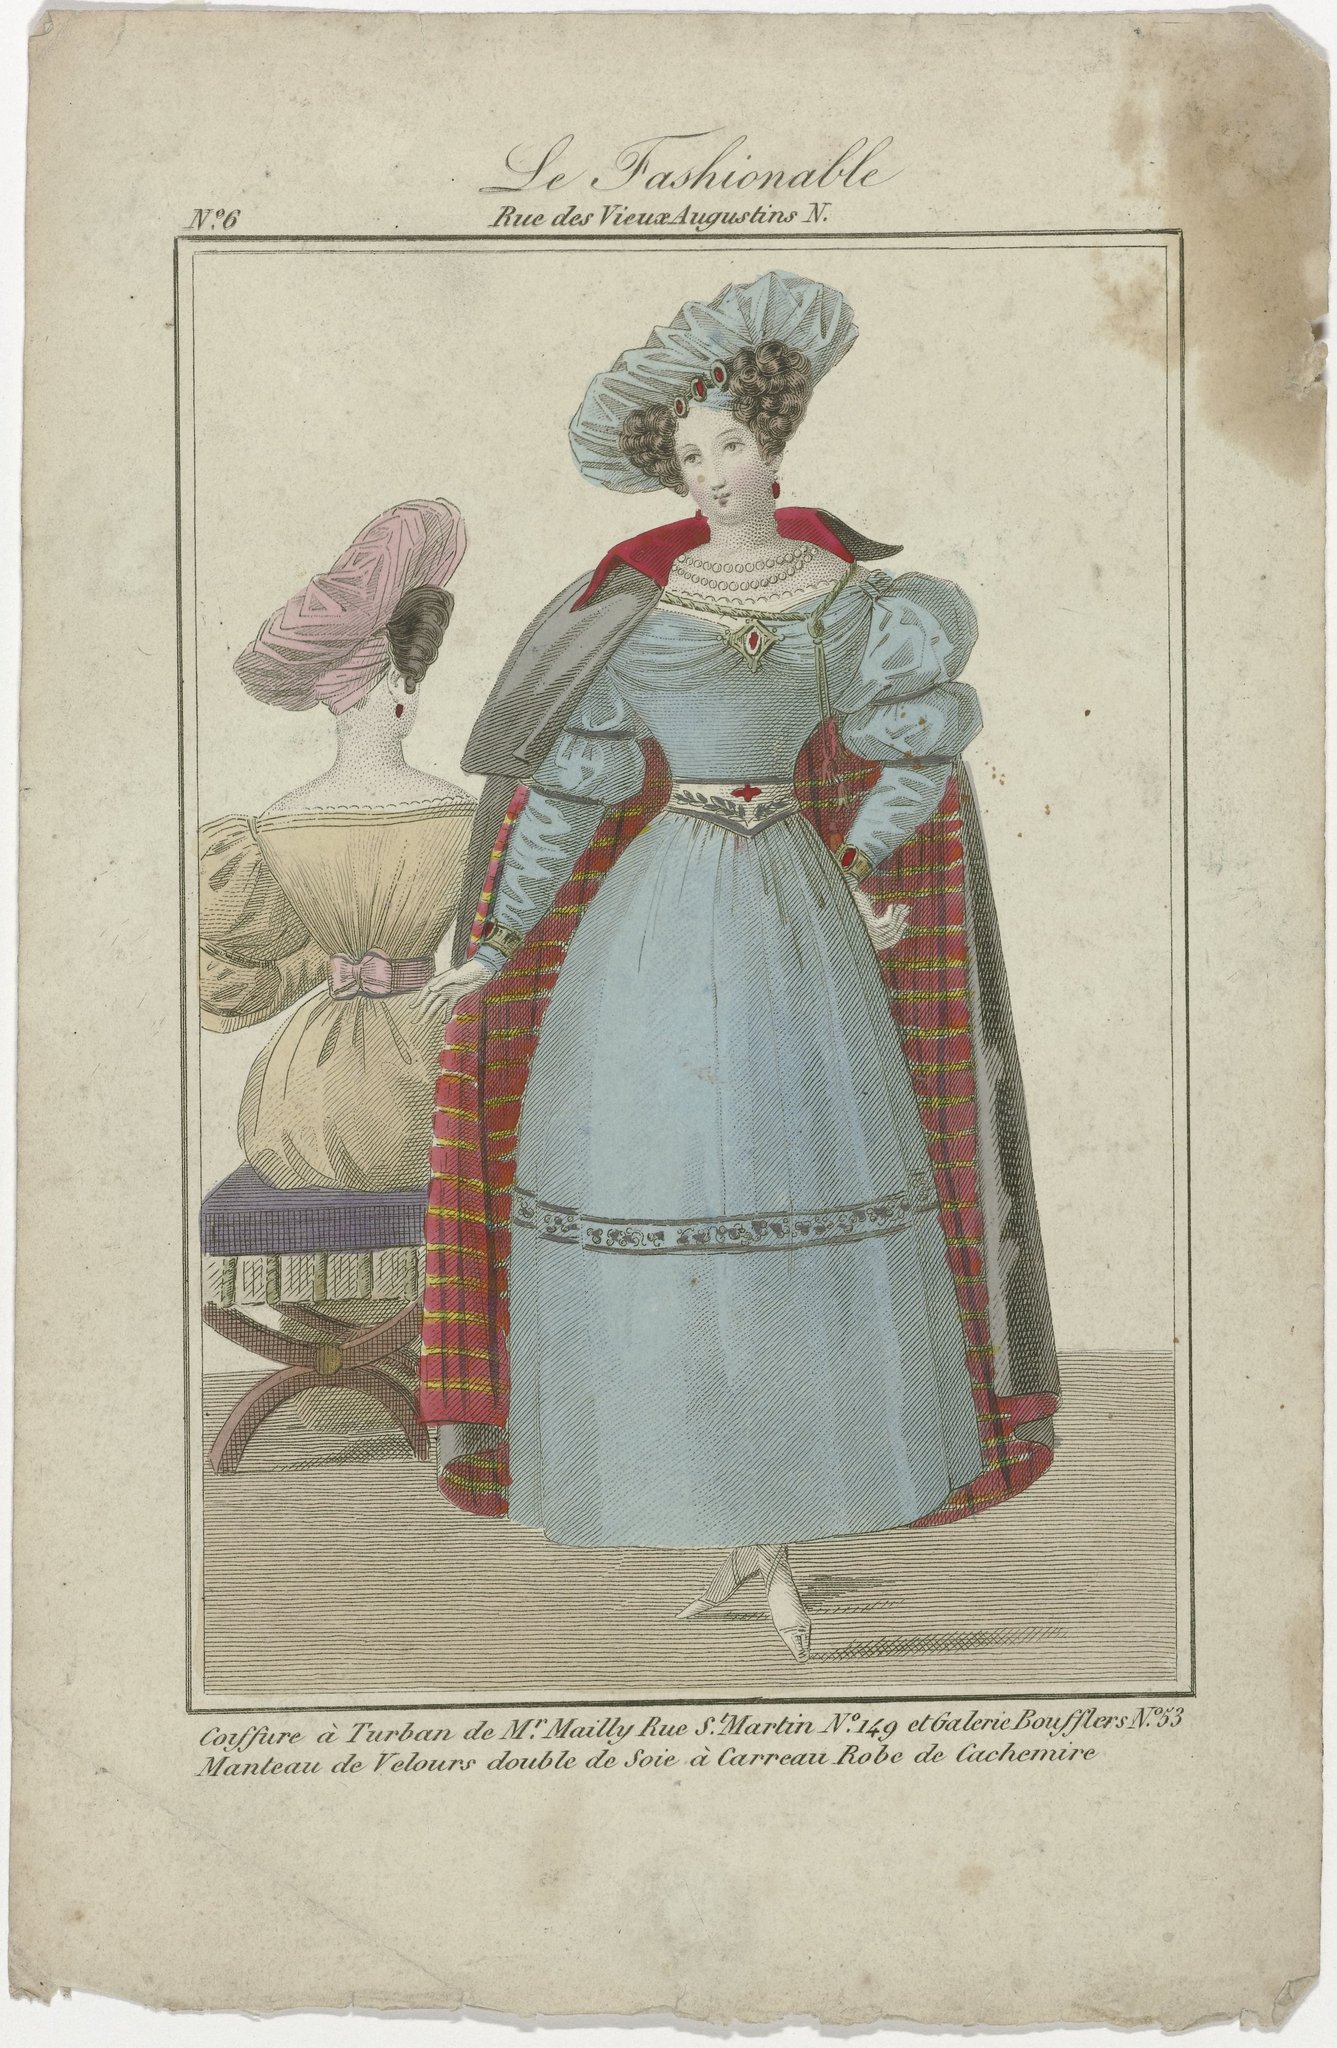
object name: fashion print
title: Le Fashionable, 1829, No. 6: Coiffure à Turban (...)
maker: Anonymous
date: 1829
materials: paper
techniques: engraving, hand coloring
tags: ear-rings (+ women's clothes), brooch, agraffe, clasp (+ women's clothes), head-gear: turban (+ women's clothes), coat (+ women's clothes), styles of hairdress - aa - ~ women, fashion plates, shoes, sandals (+ women's clothes), dress, gown (+ women's clothes), bracelet, wristlet (+ women's clothes), necklace (+ women's clothes)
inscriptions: title: ‘Le Fashionable’, address: ‘Rue des Vieux Augustins N.’, caption: ‘Coiffure à Turban de M.r Mailly Rue S.t Martin No. 149 et Galerie Boufflers No. 53 Manteau de Velours double de soie à carreau Robe de Cachemire’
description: 'Coeffure' met tulband van Mr Mailly. Mantel van fluweel, gevoerd met geruite zijde. Japon van kasjmier. Verdere accessoires: oorbellen, collier bestaande uit twee snoeren, broche, armbanden om beide polsen, platte schoenen met gekruiste banden. Prent uit het modetijdschrift Le Fashionable (19-10-1928 tot 15-2-1829. nrs. 1 t/m 18)